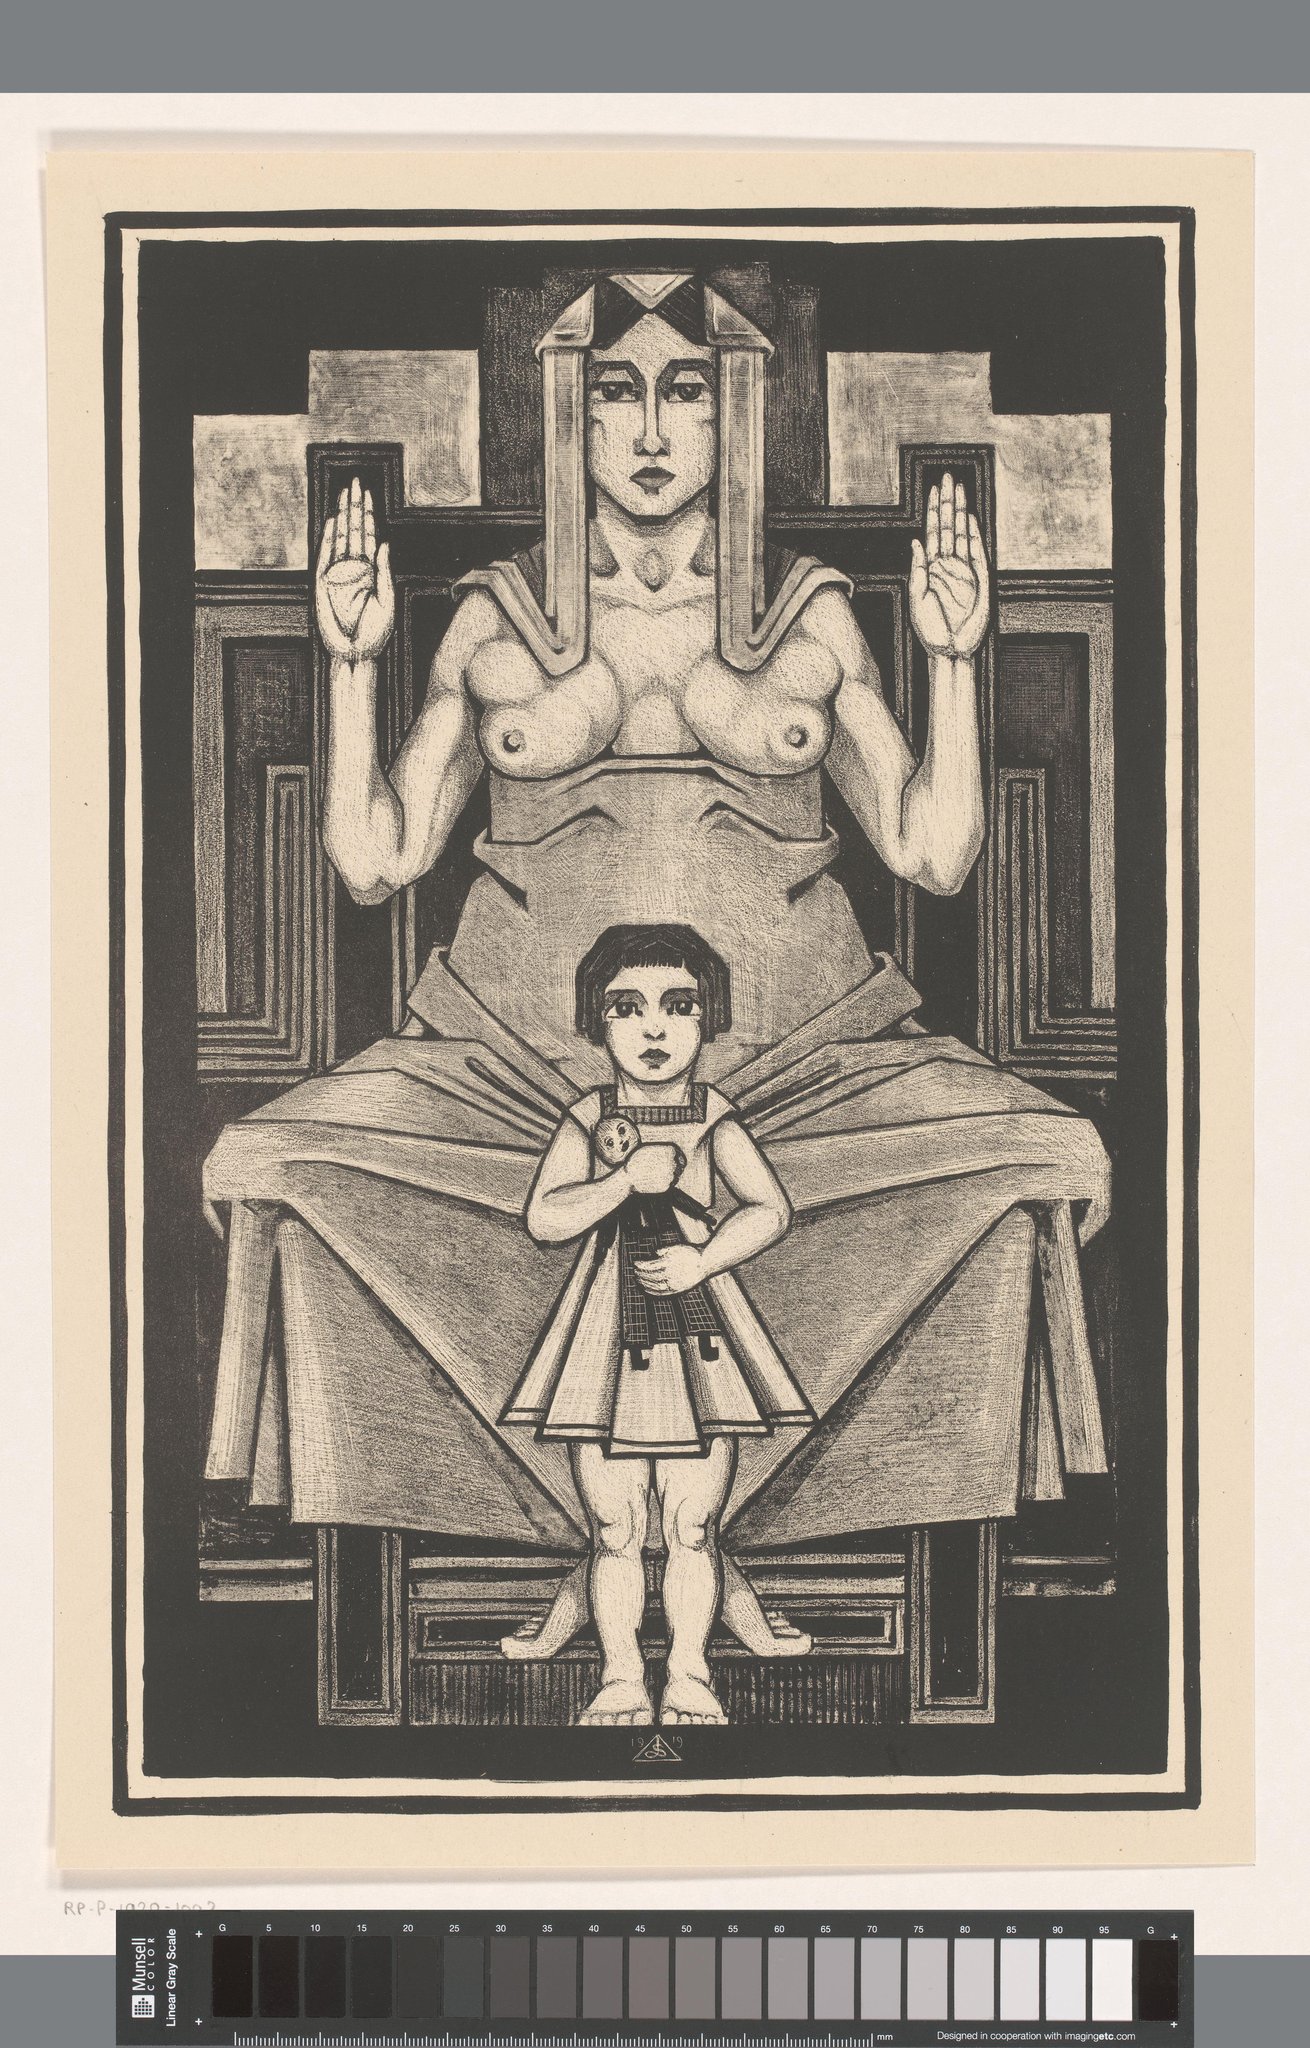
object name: print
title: Moeder met kind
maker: henk schilling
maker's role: print maker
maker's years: 1893-1942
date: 1919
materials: paper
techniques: lithograph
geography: netherlands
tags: mother and baby or young child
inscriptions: collector's mark: Lugt 2233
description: Een vrouw met ontblote borsten zit op een troon en houdt beide handen omhoog. Voor haar staat een meisje dat een pop vasthoudt.